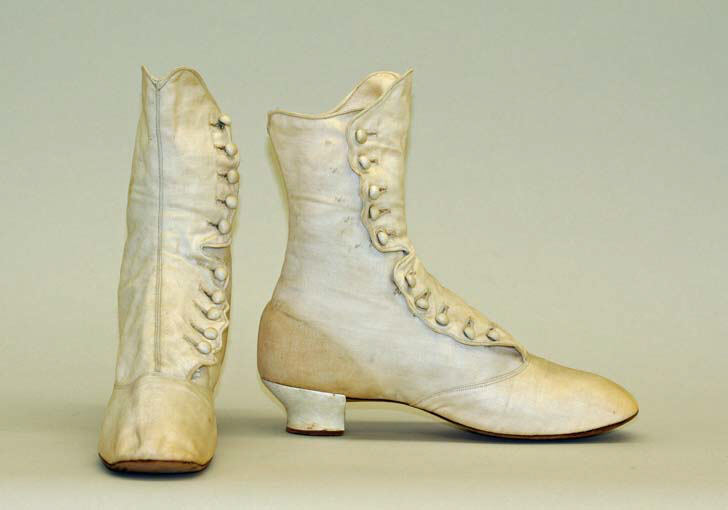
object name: shoe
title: Shoes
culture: american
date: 1876